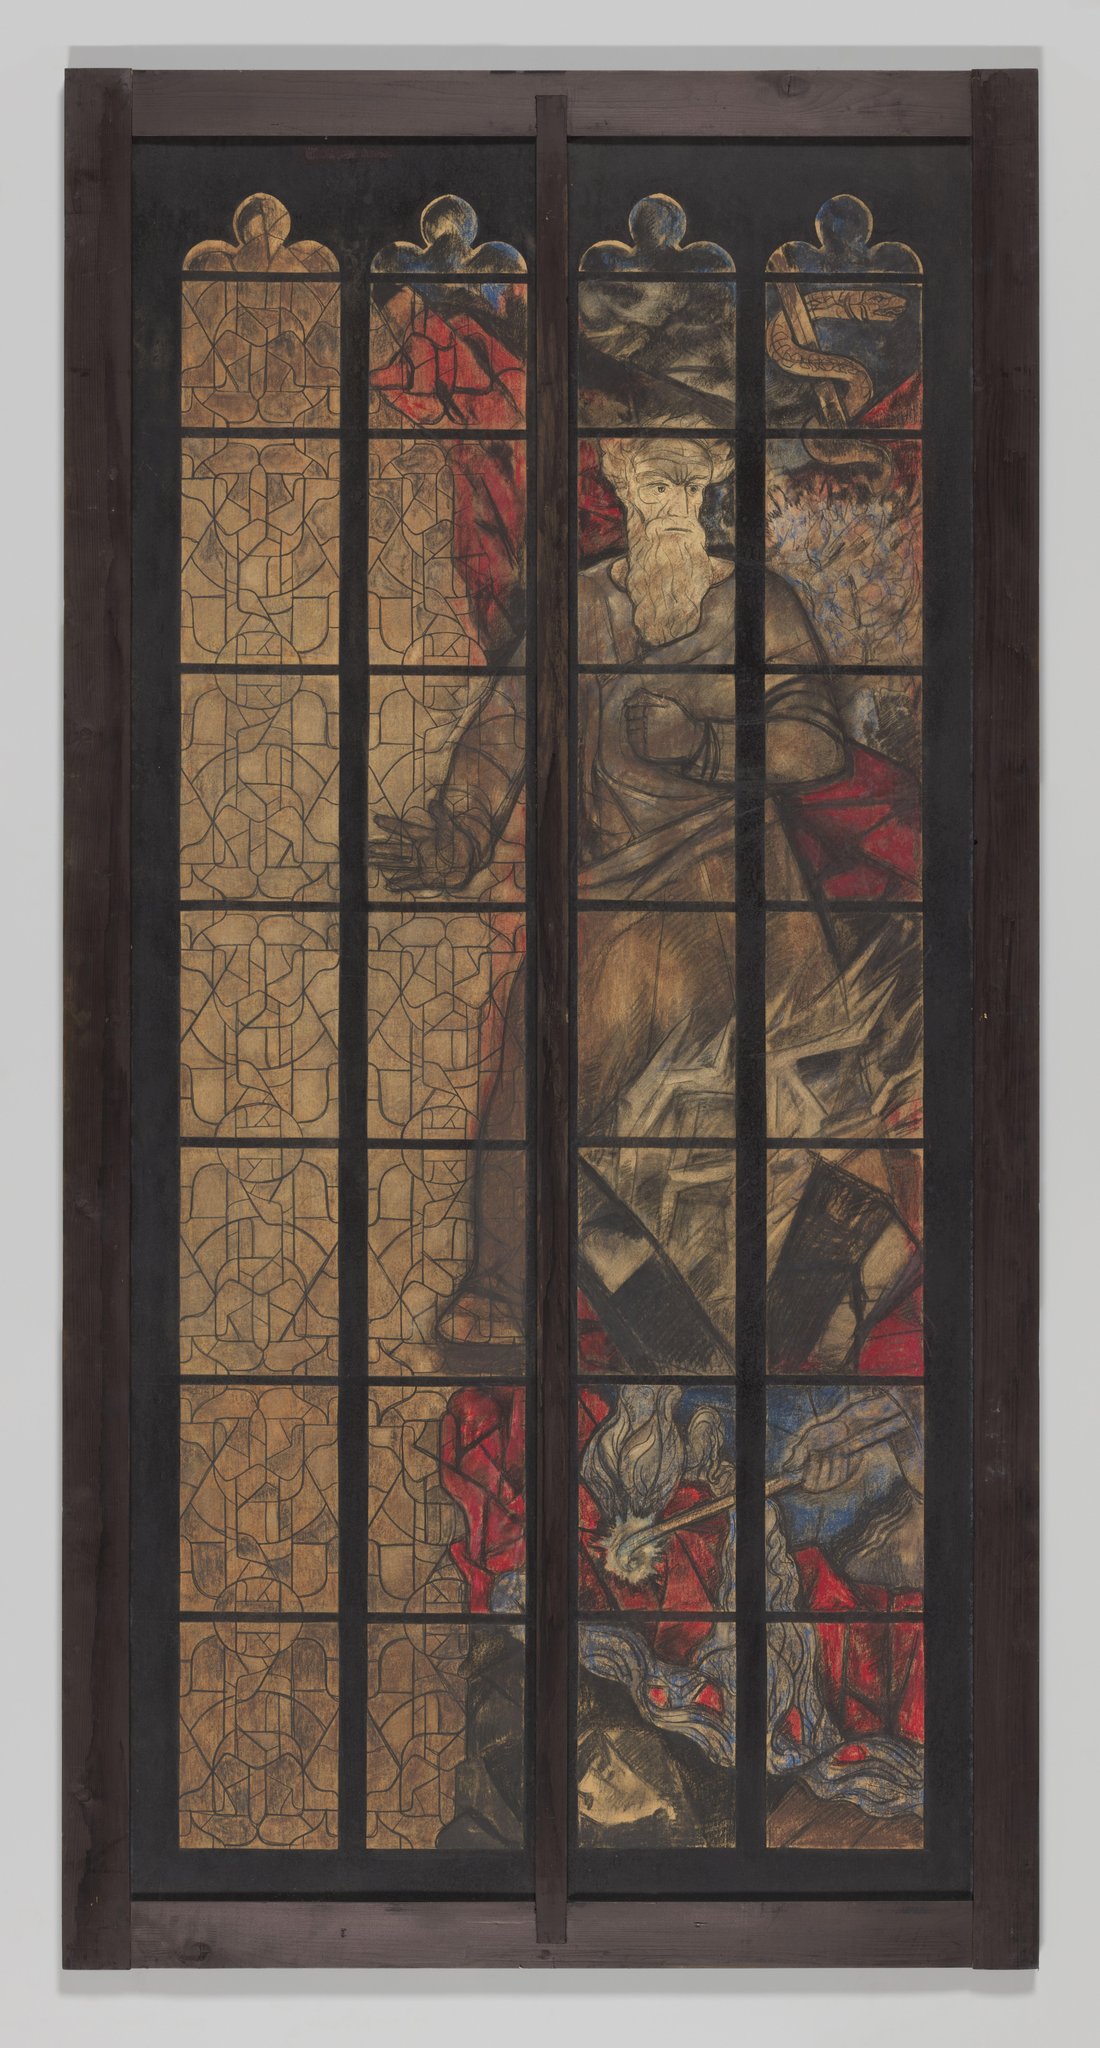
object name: design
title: Ontwerp voor het bovenste gedeelte van een raam in het Noordertransept in de Dom te Utrecht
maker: richard nicolaüs roland holst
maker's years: 1868-1938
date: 1868-1938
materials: cardboard, chalk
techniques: brush